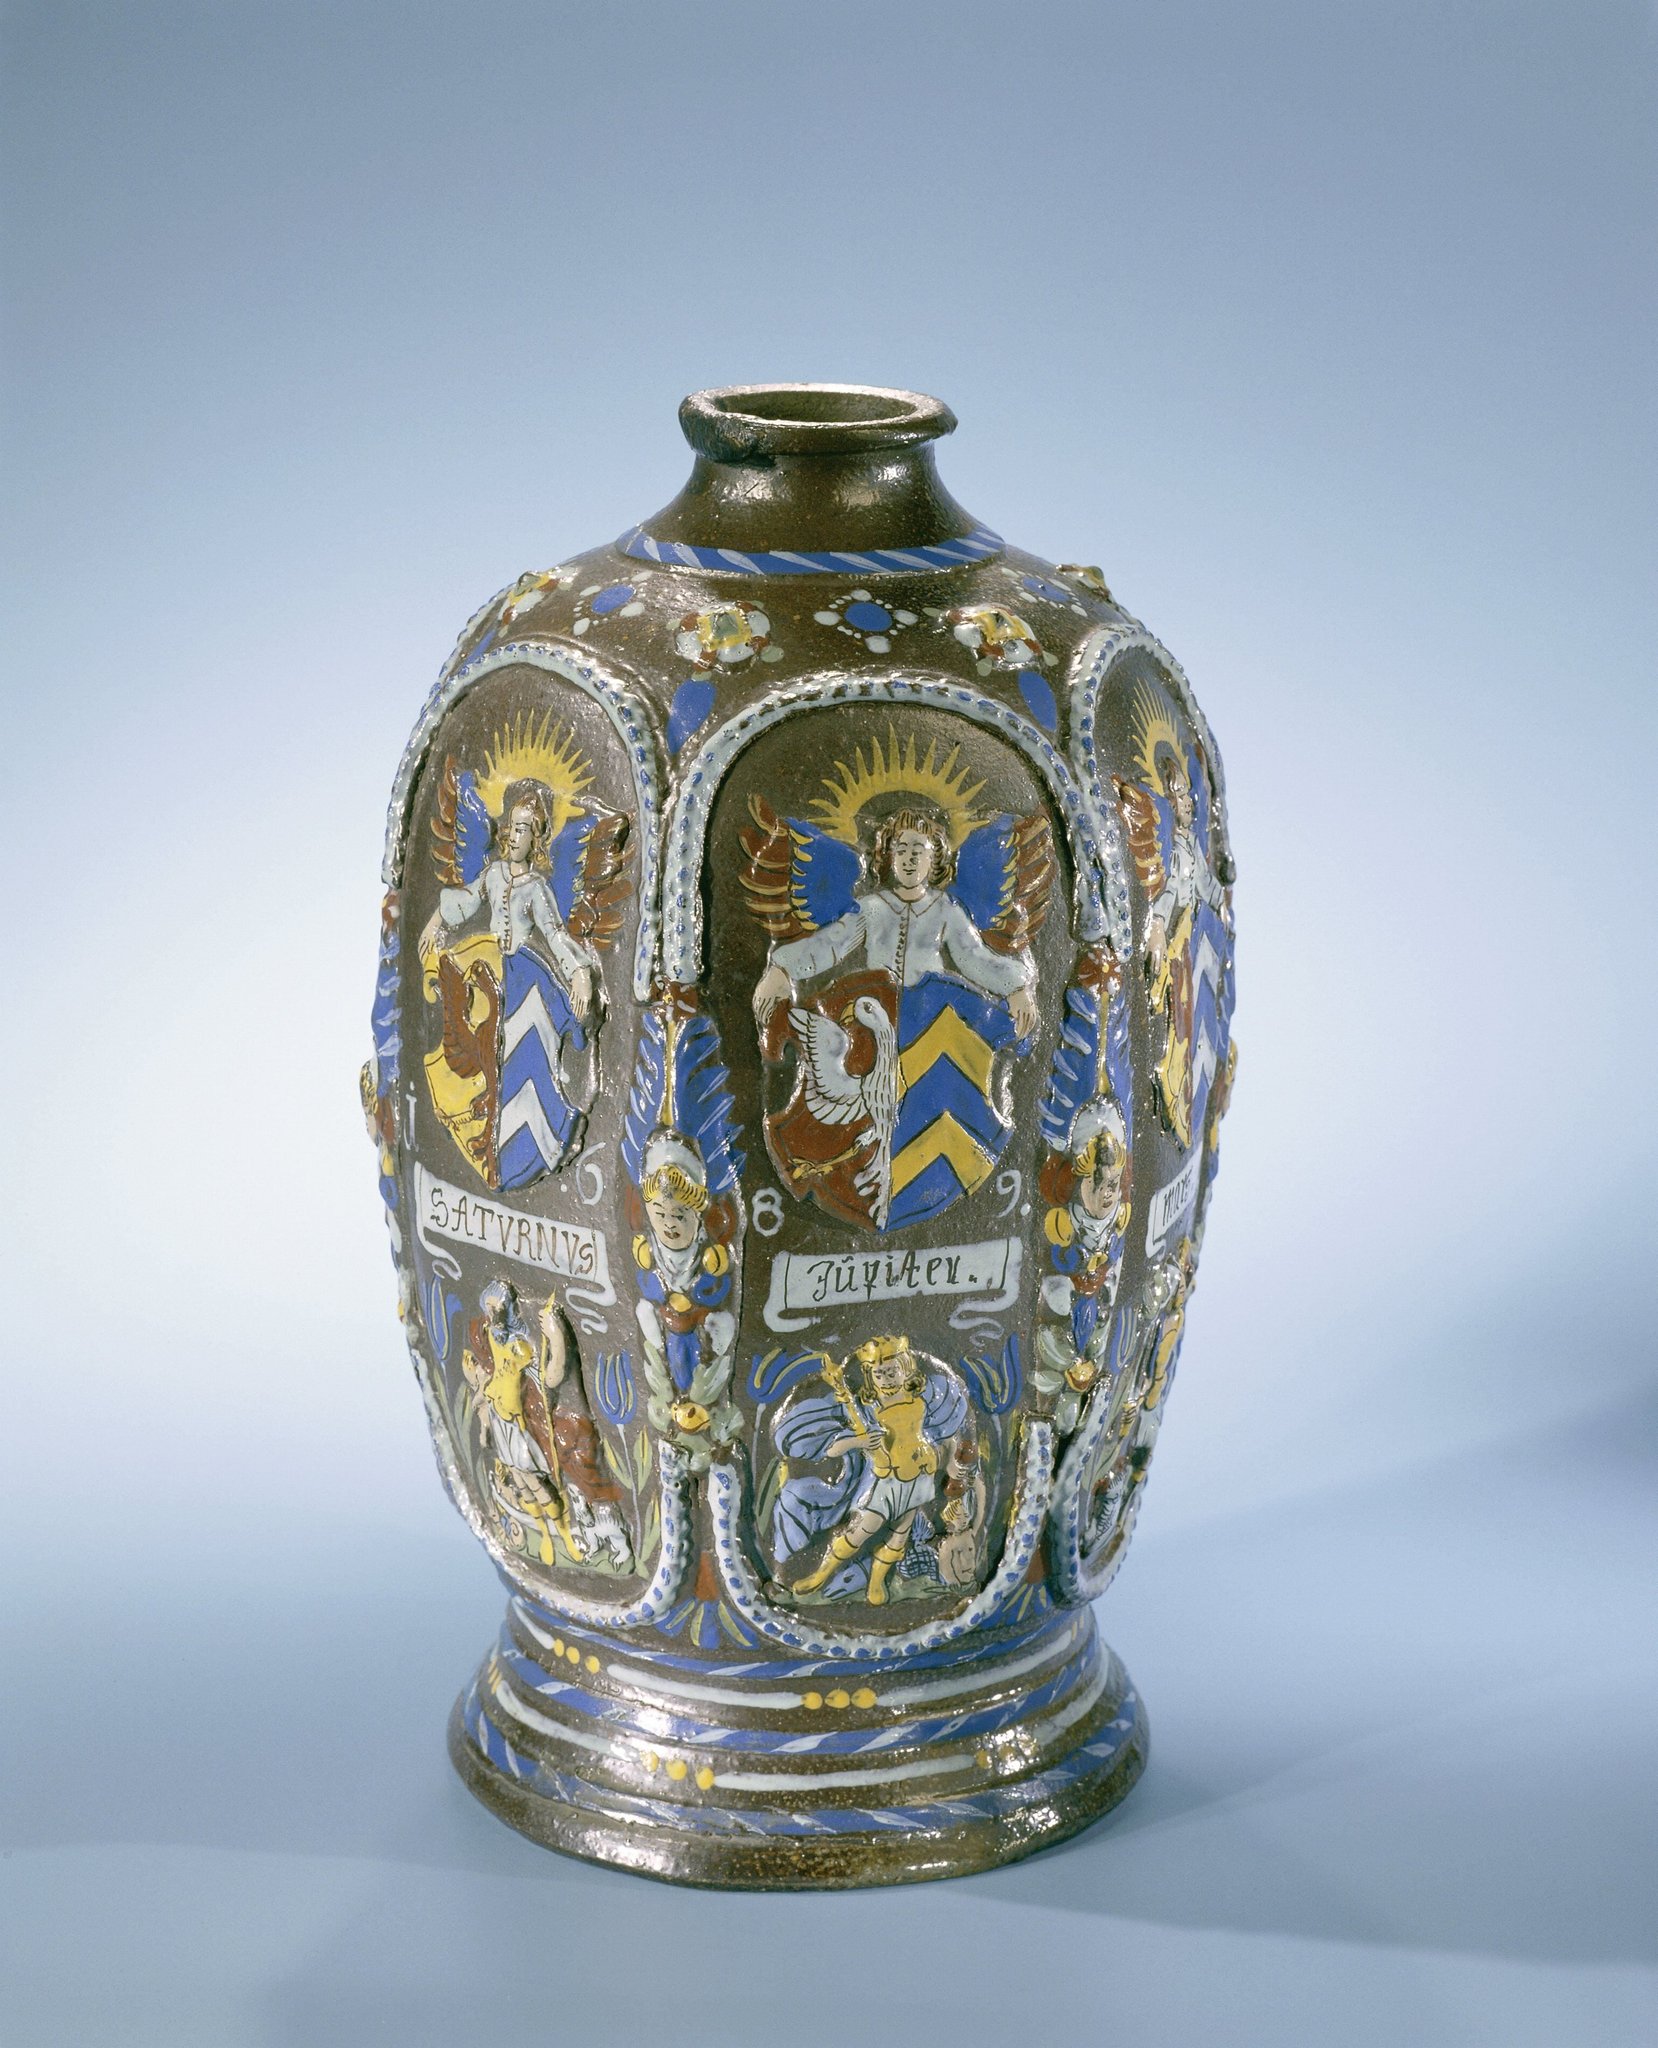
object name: kruke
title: Hexagonal bottle (kruke) with the planets and a coat of arms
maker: Anonymous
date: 1689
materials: engobe, glaze, stoneware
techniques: firing, forming, relief, turning, vitrification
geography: creussen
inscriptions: date: ‘1689’, inscription: ‘SATVRNVS/ JUPITER/ MARS/ SOLL/ VENUS/ MERCURIUS’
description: Zeshoekige fles (kruke) van steengoed op spreidende voet en met een eivormig lichaam en smalle, korte nek. Profielen op de voet. Bedekt met een bruine engobe en beschilderd met emailkleuren in blauw, rood, groen, geel, zwart en wit. In elk vak een gedrukte en opgelegde decoratie in reliëf van een personificatie van de planeten (SATVRNVS, JUPITER, MARS, SOLL, VENUS, MERCURIUS) en een wapen gedragen door een engel. In de vakken van Saturnus en Jupiter de datum '1689'. Op de schouder bloemen in reliëf. Het wapen is een aangepaste versie van die van de Neurenbergse familie Neudörffer. Creussen.